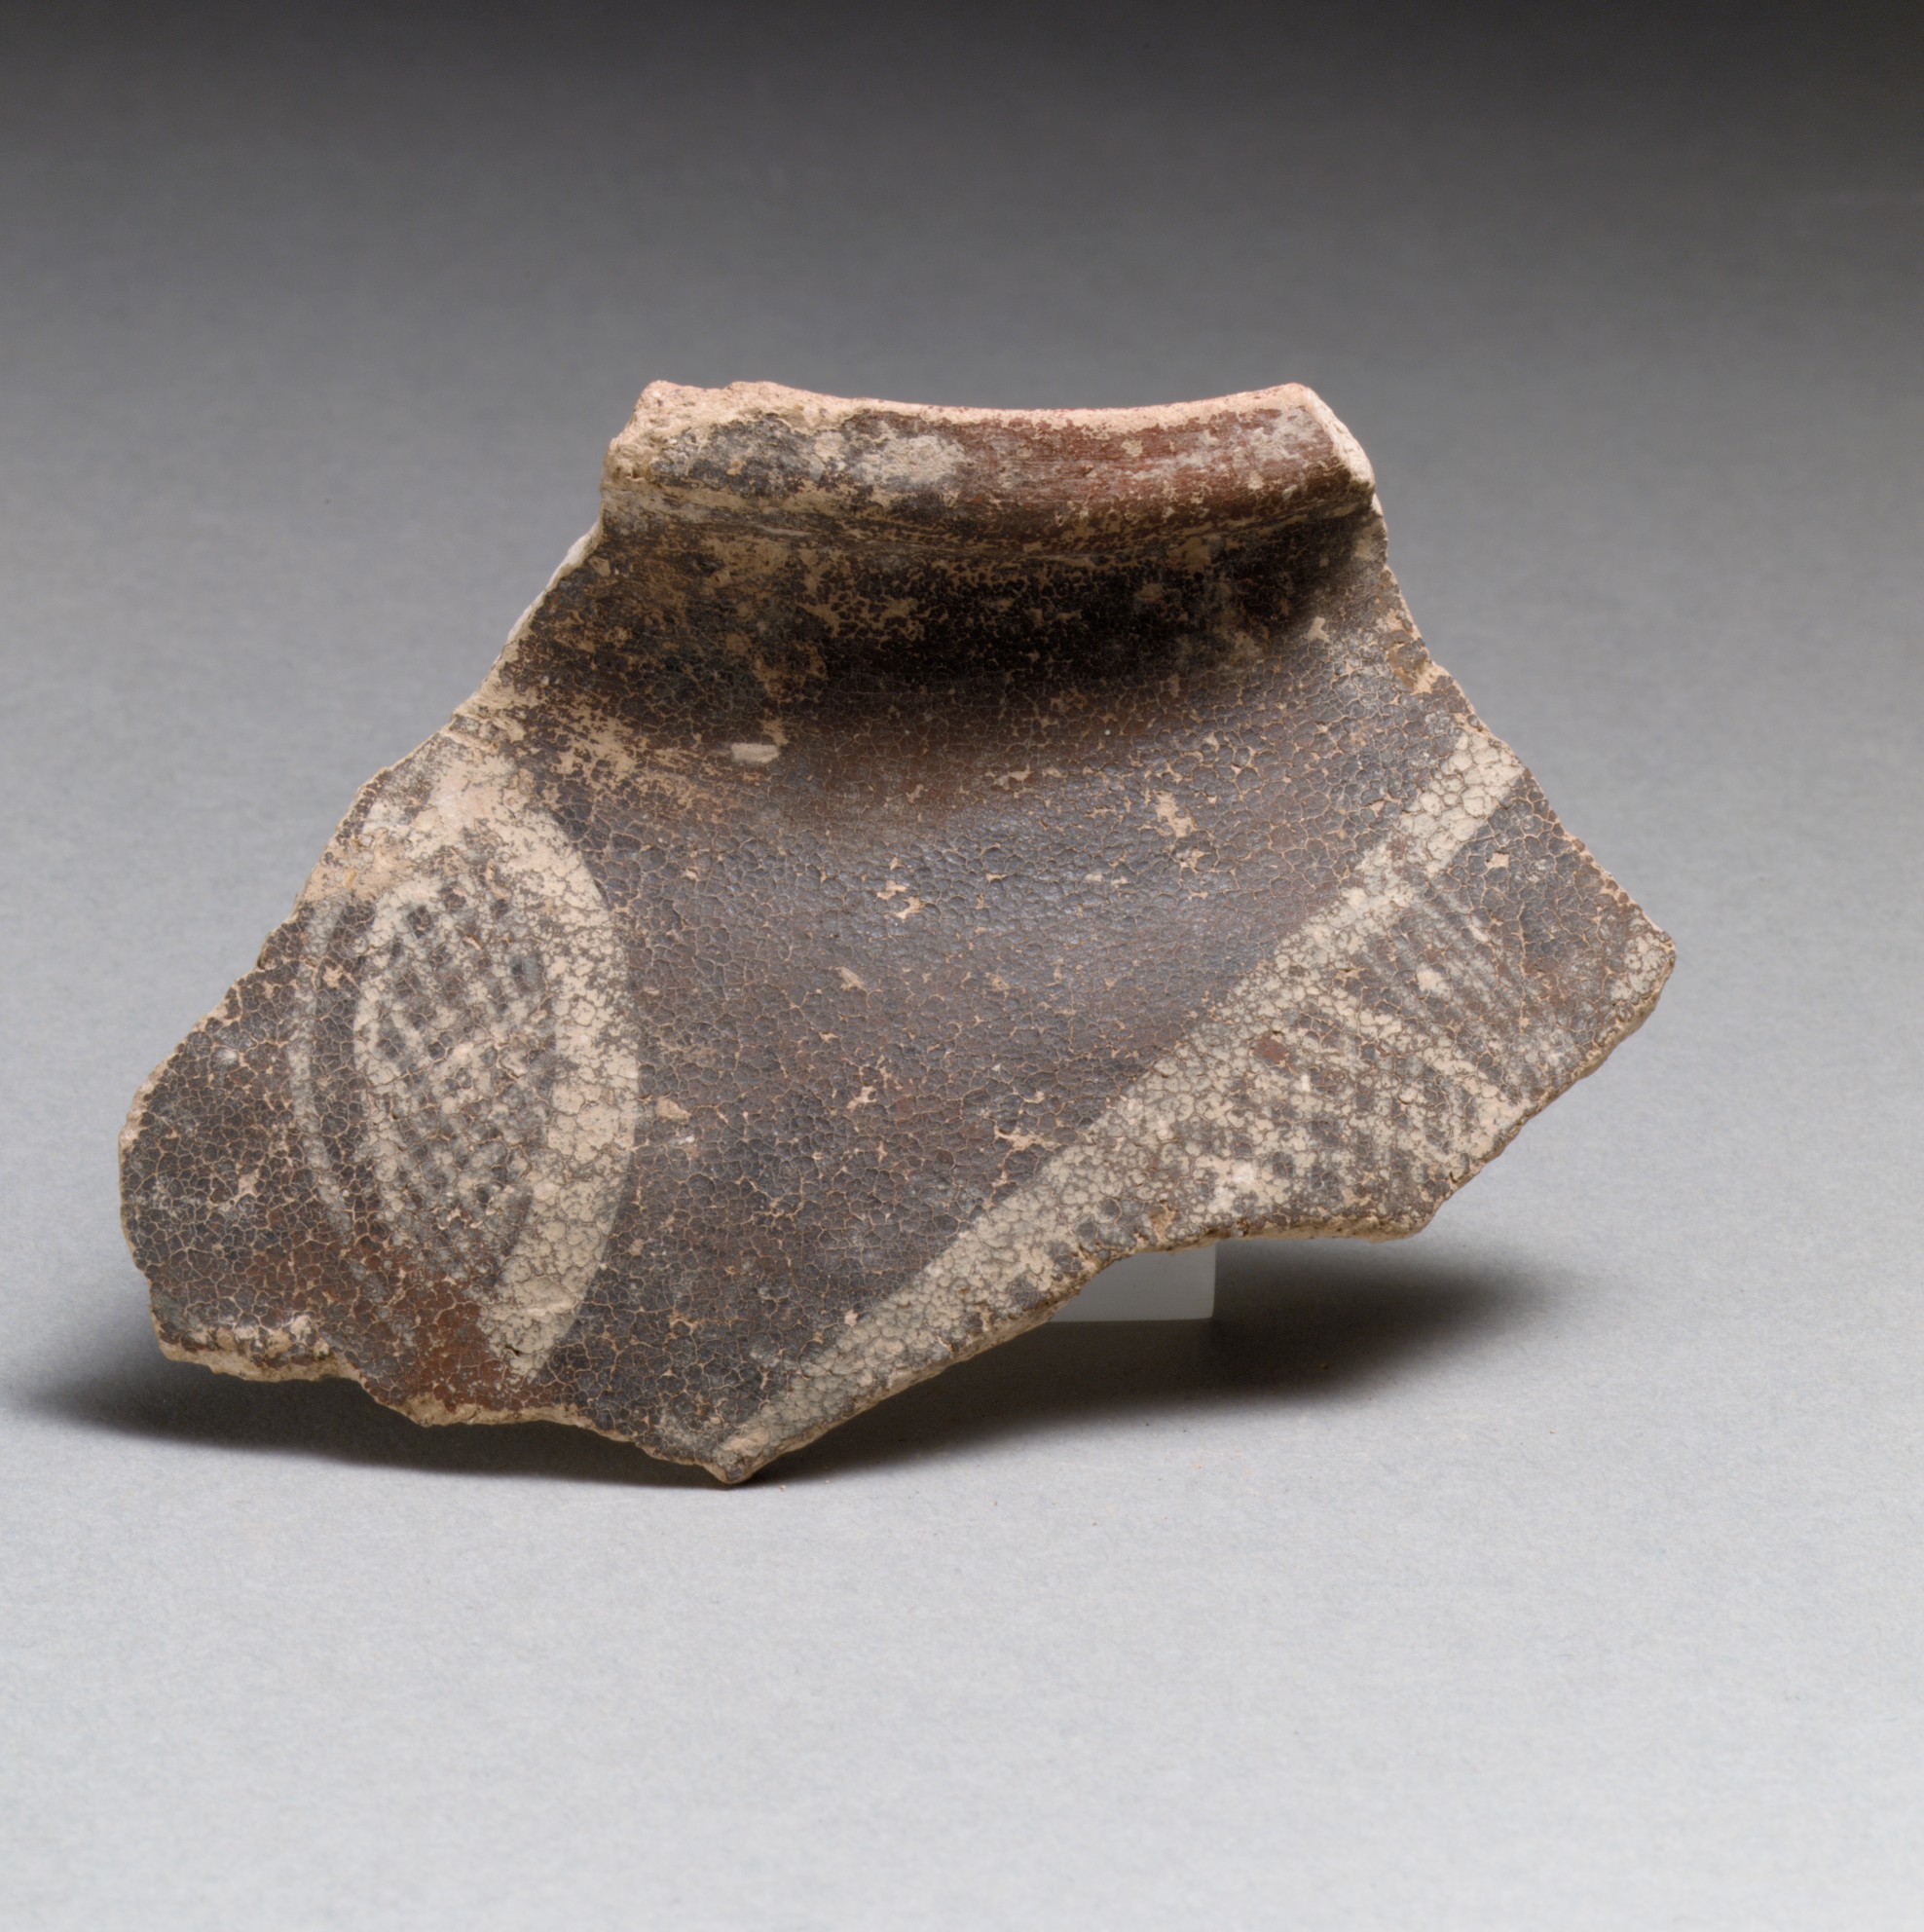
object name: vase fragment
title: Terracotta rim fragment with cross-hatched lozenges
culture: minoan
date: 2300-2100 BCE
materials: terracotta